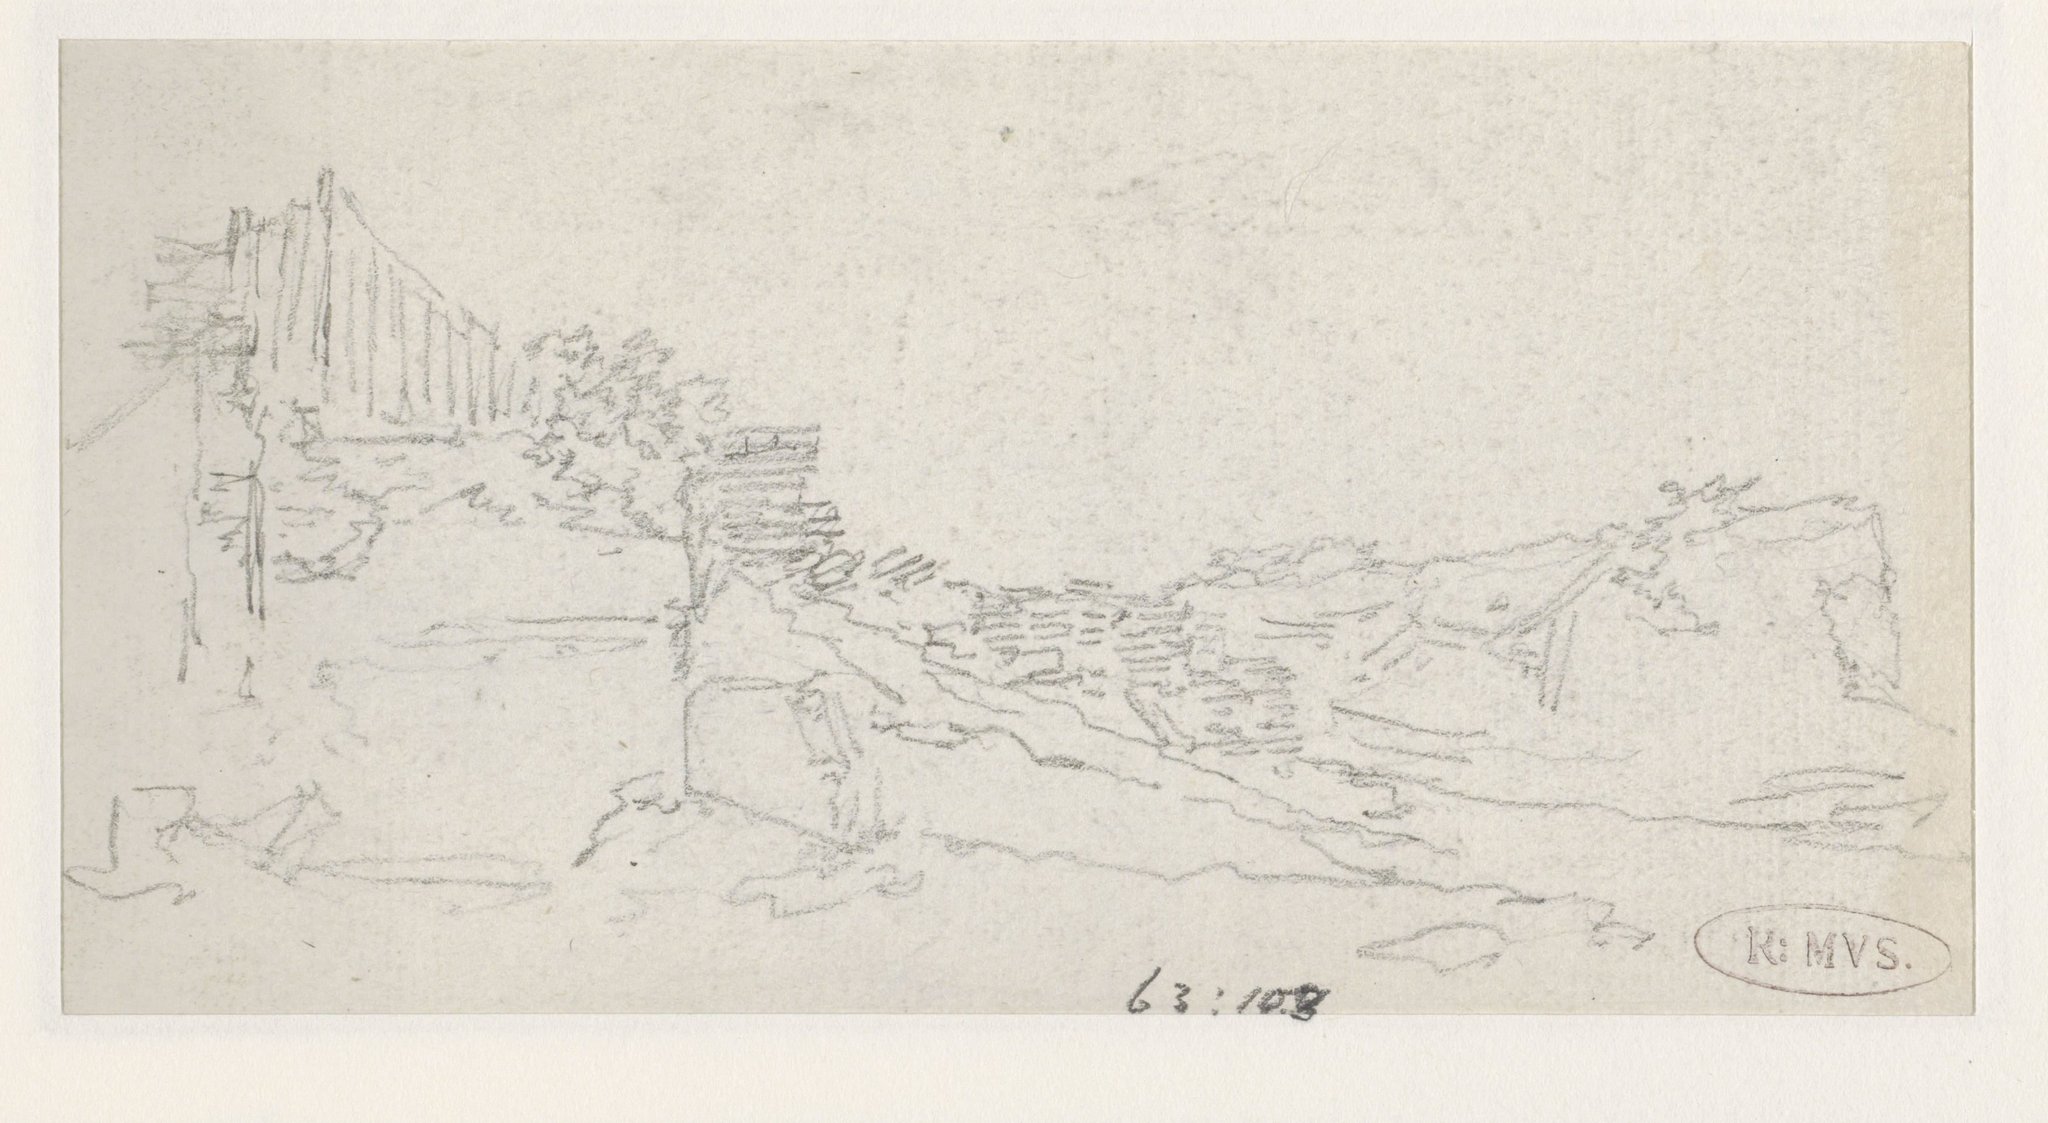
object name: drawing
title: Schets van een ruïne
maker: georges michel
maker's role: draughtsman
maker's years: 1763-1843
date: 1773-1843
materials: paper, pencil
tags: landscape with ruins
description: Een van 120 tekeningen, afkomstig uit een 19e eeuws album met tekeningen van Georges Michel.